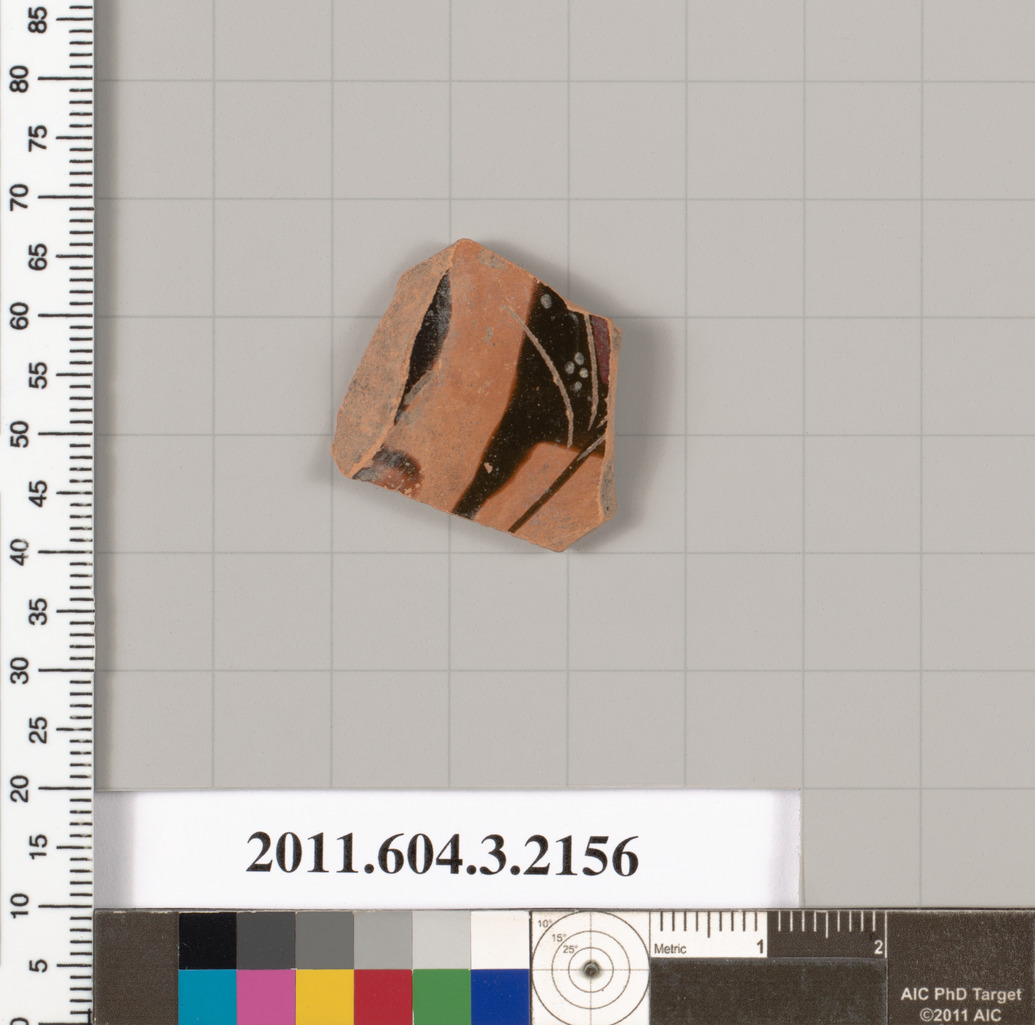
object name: kylix fragment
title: Terracotta fragment of a kylix (drinking cup)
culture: greek, attic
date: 534-501 BCE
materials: terracotta